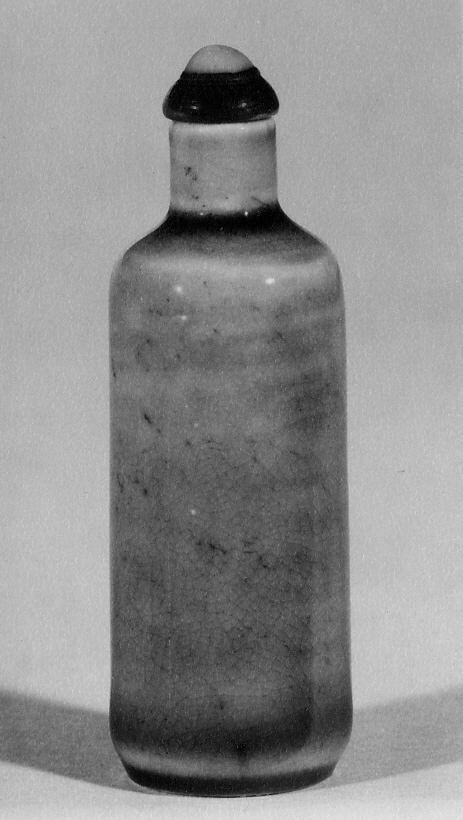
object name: snuff bottle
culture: chinese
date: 1701-1800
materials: ivory, porcelain